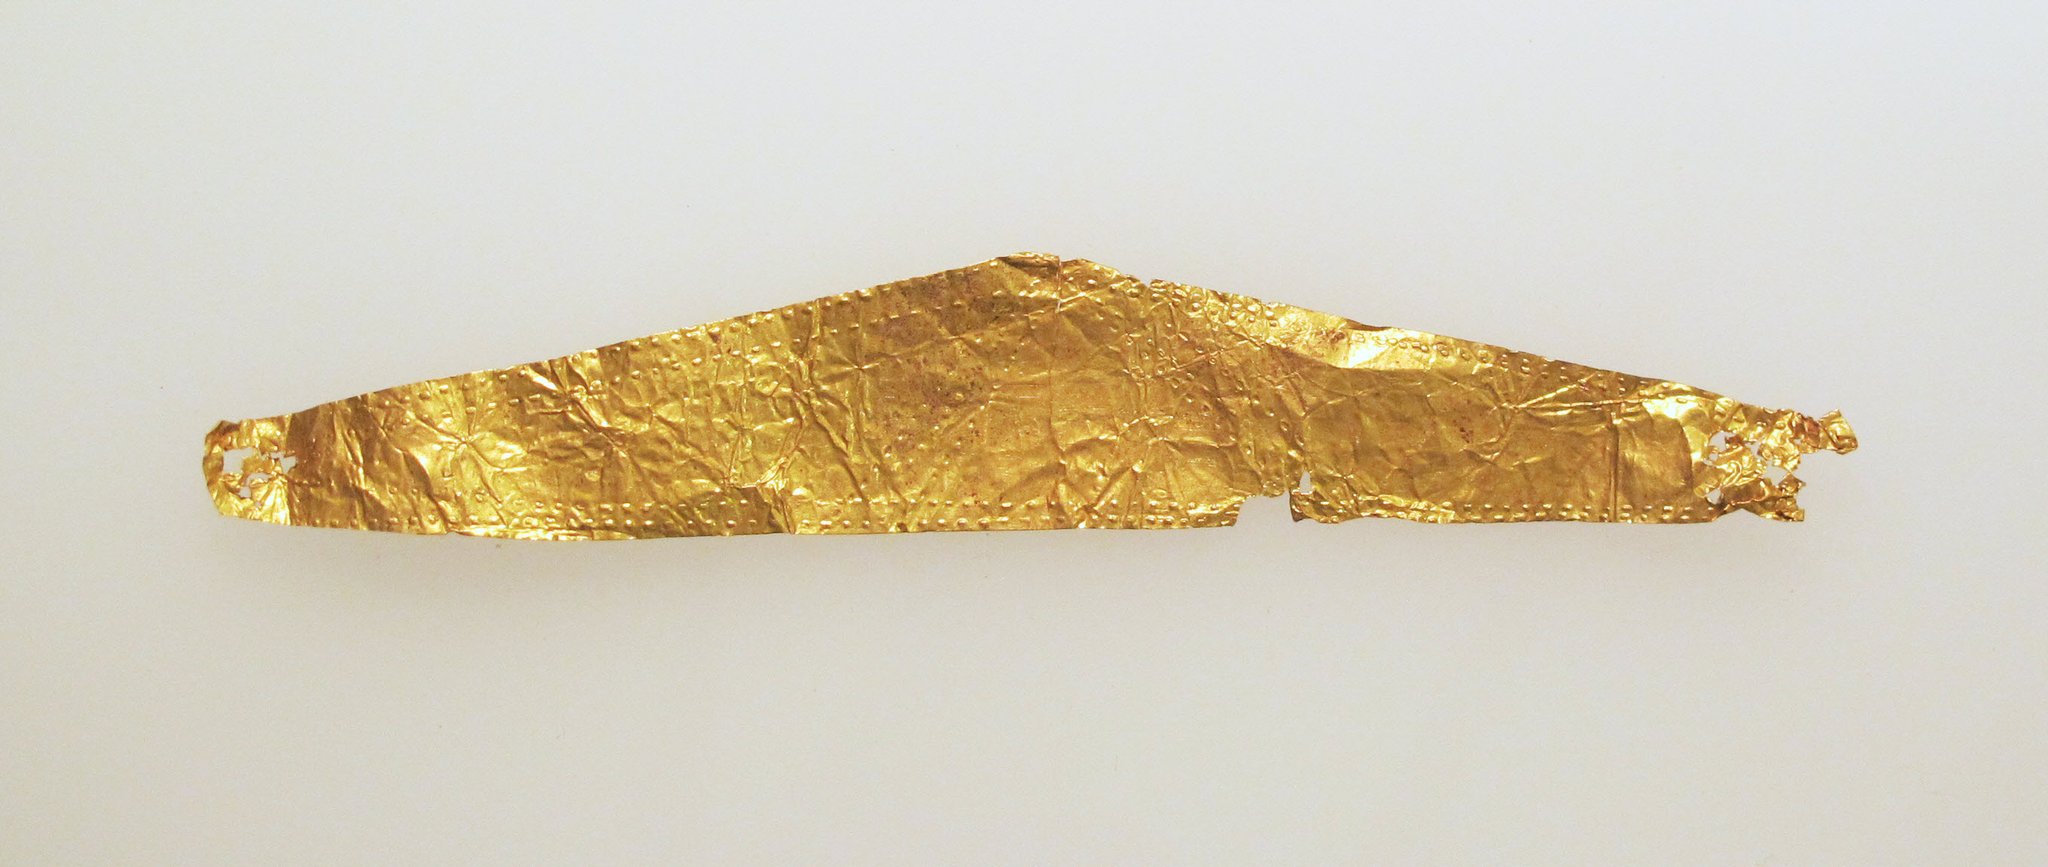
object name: frontlet of gold leaf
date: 7000 BCE-330 CE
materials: gold